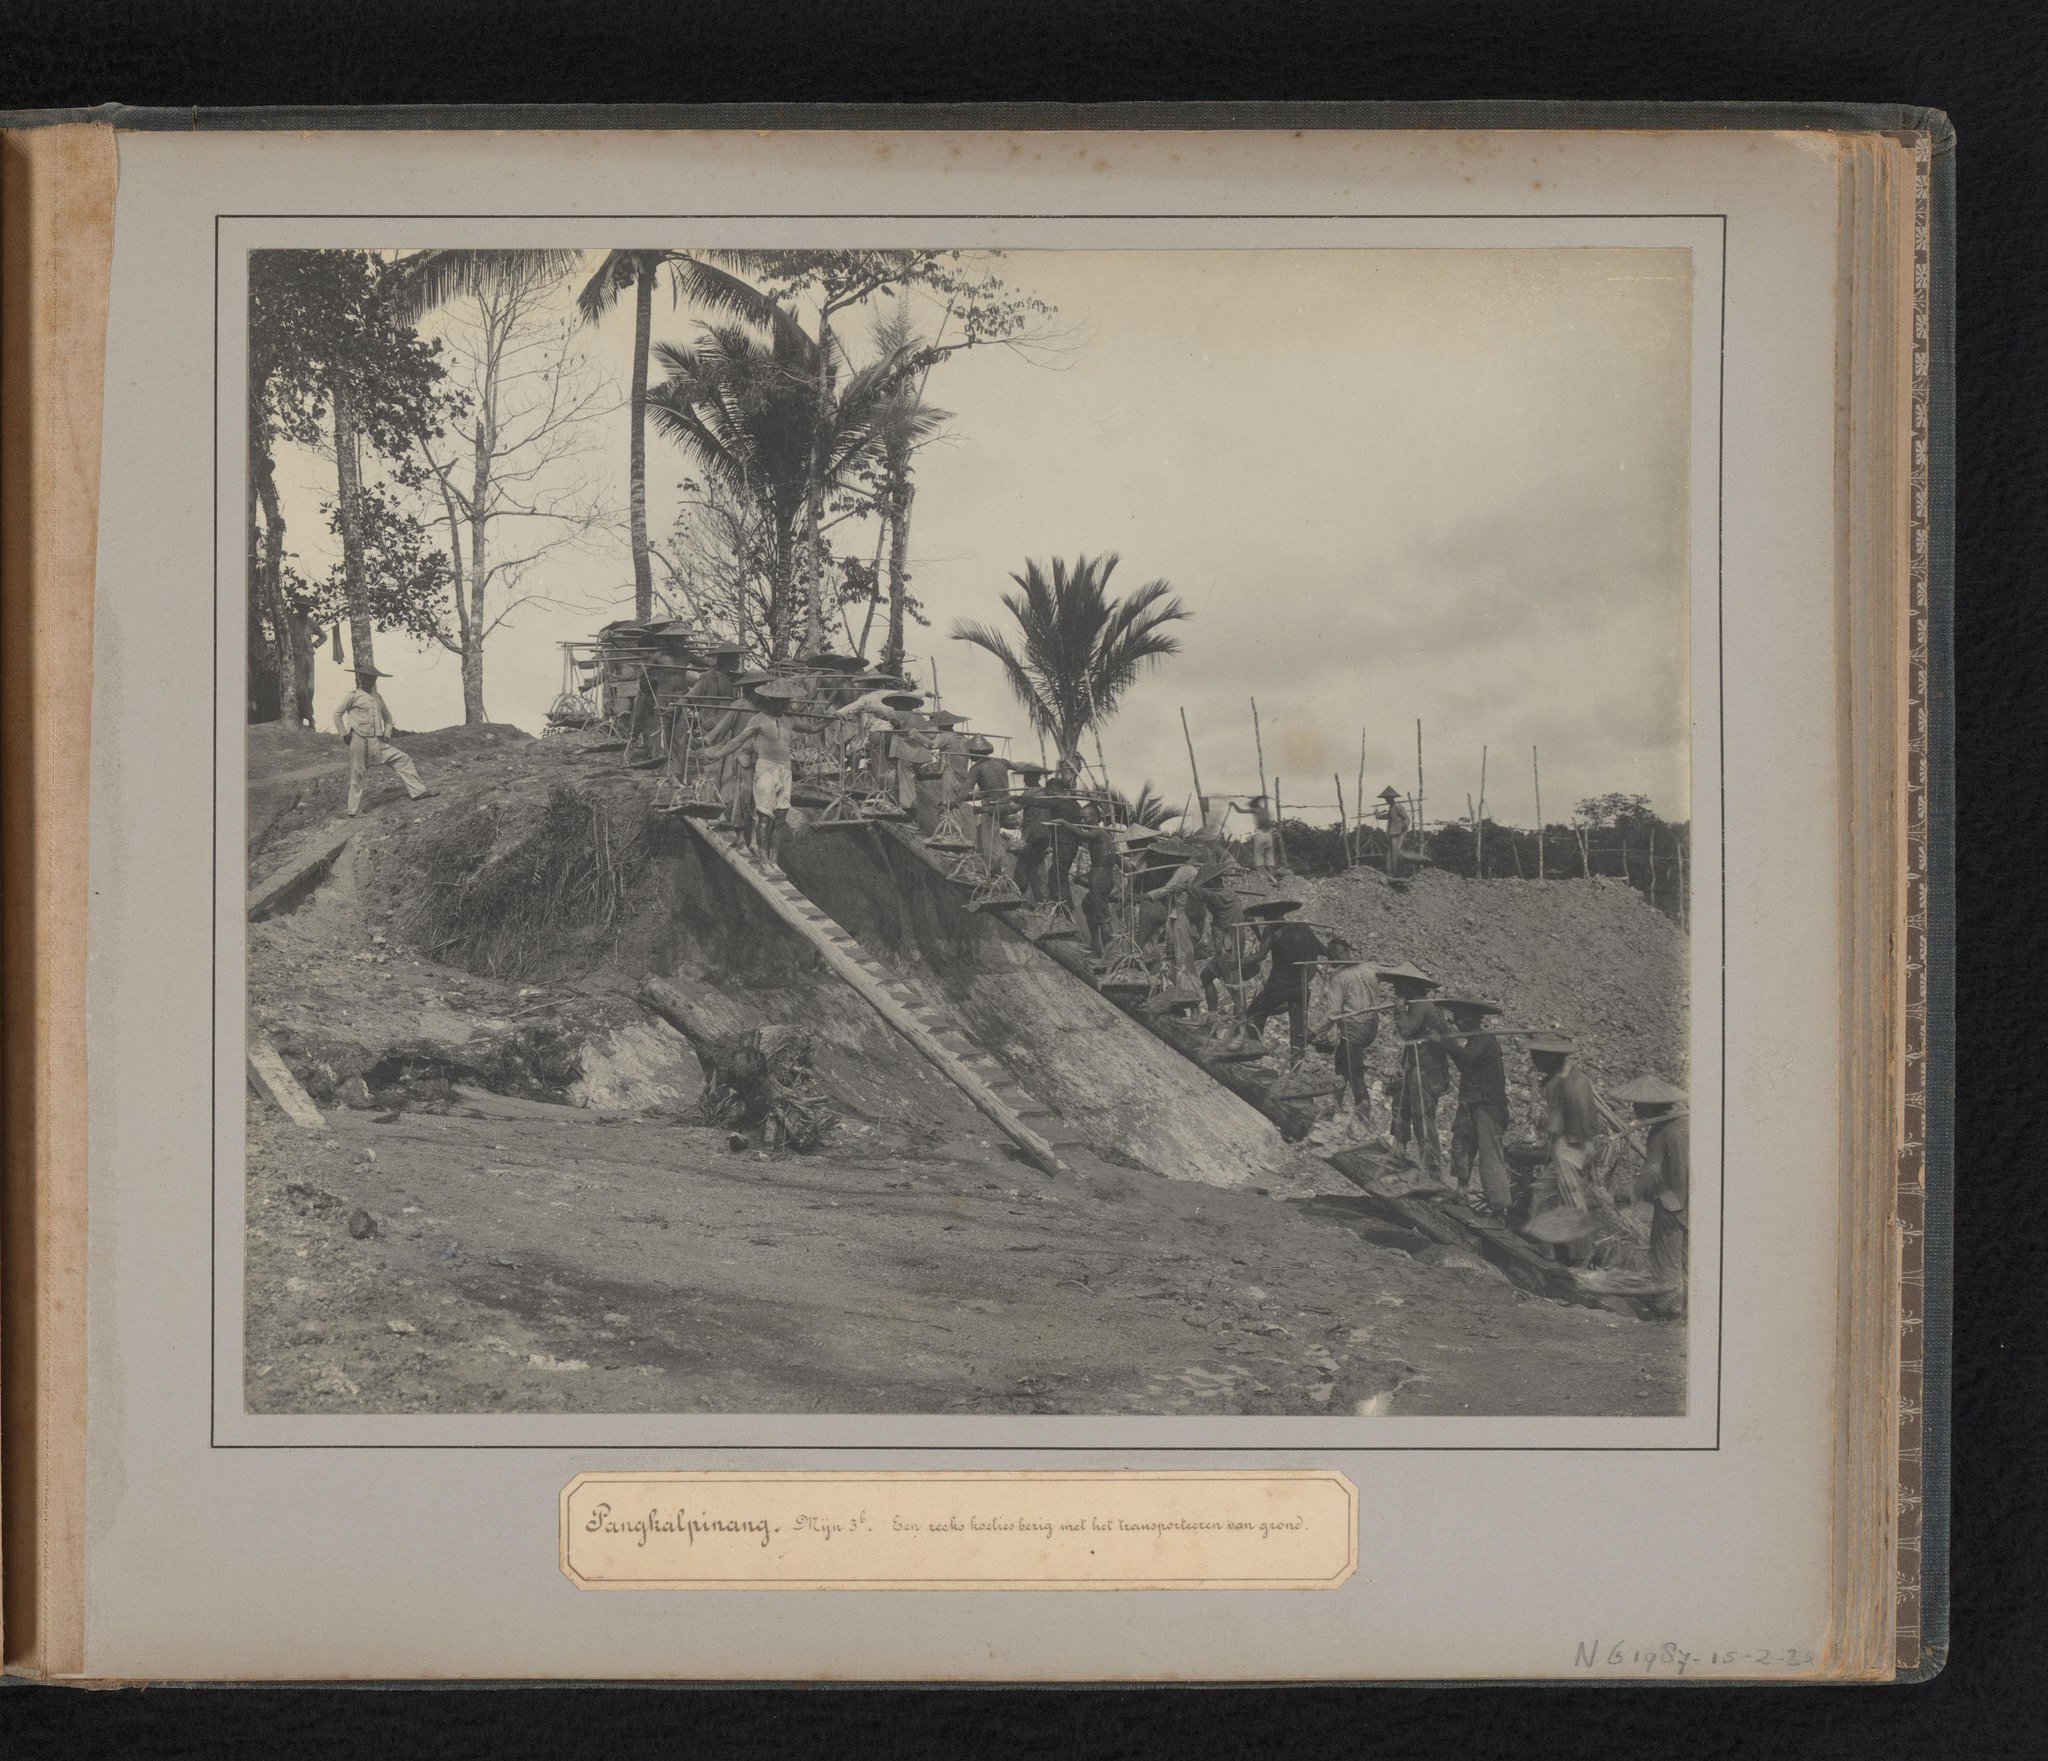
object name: photograph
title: Pangkalpinang. Mijn 3b. Een reeks koelies bezig met het transporteeren van grond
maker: Anonymous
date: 1907-1919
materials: cardboard, photographic support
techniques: gelatin silver print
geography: bangka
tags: robert julius boers, colonial system, opencast mine; strip mining, minerals and metals: tin, working class, labourers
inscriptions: inscription: ‘Pangkalpinang. Mijn 3b. Een reeks koelies bezig met het transporteeren van grond’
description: De groeve van een open tinmijn van de Banka-tinwinning te Pangkalpinang met Chinese mijnwerkers die grond met tinerts afvoeren in draagmanden. Onderdeel van het fotoalbum over de Banka-tinwinning, ca. 1907-1919.